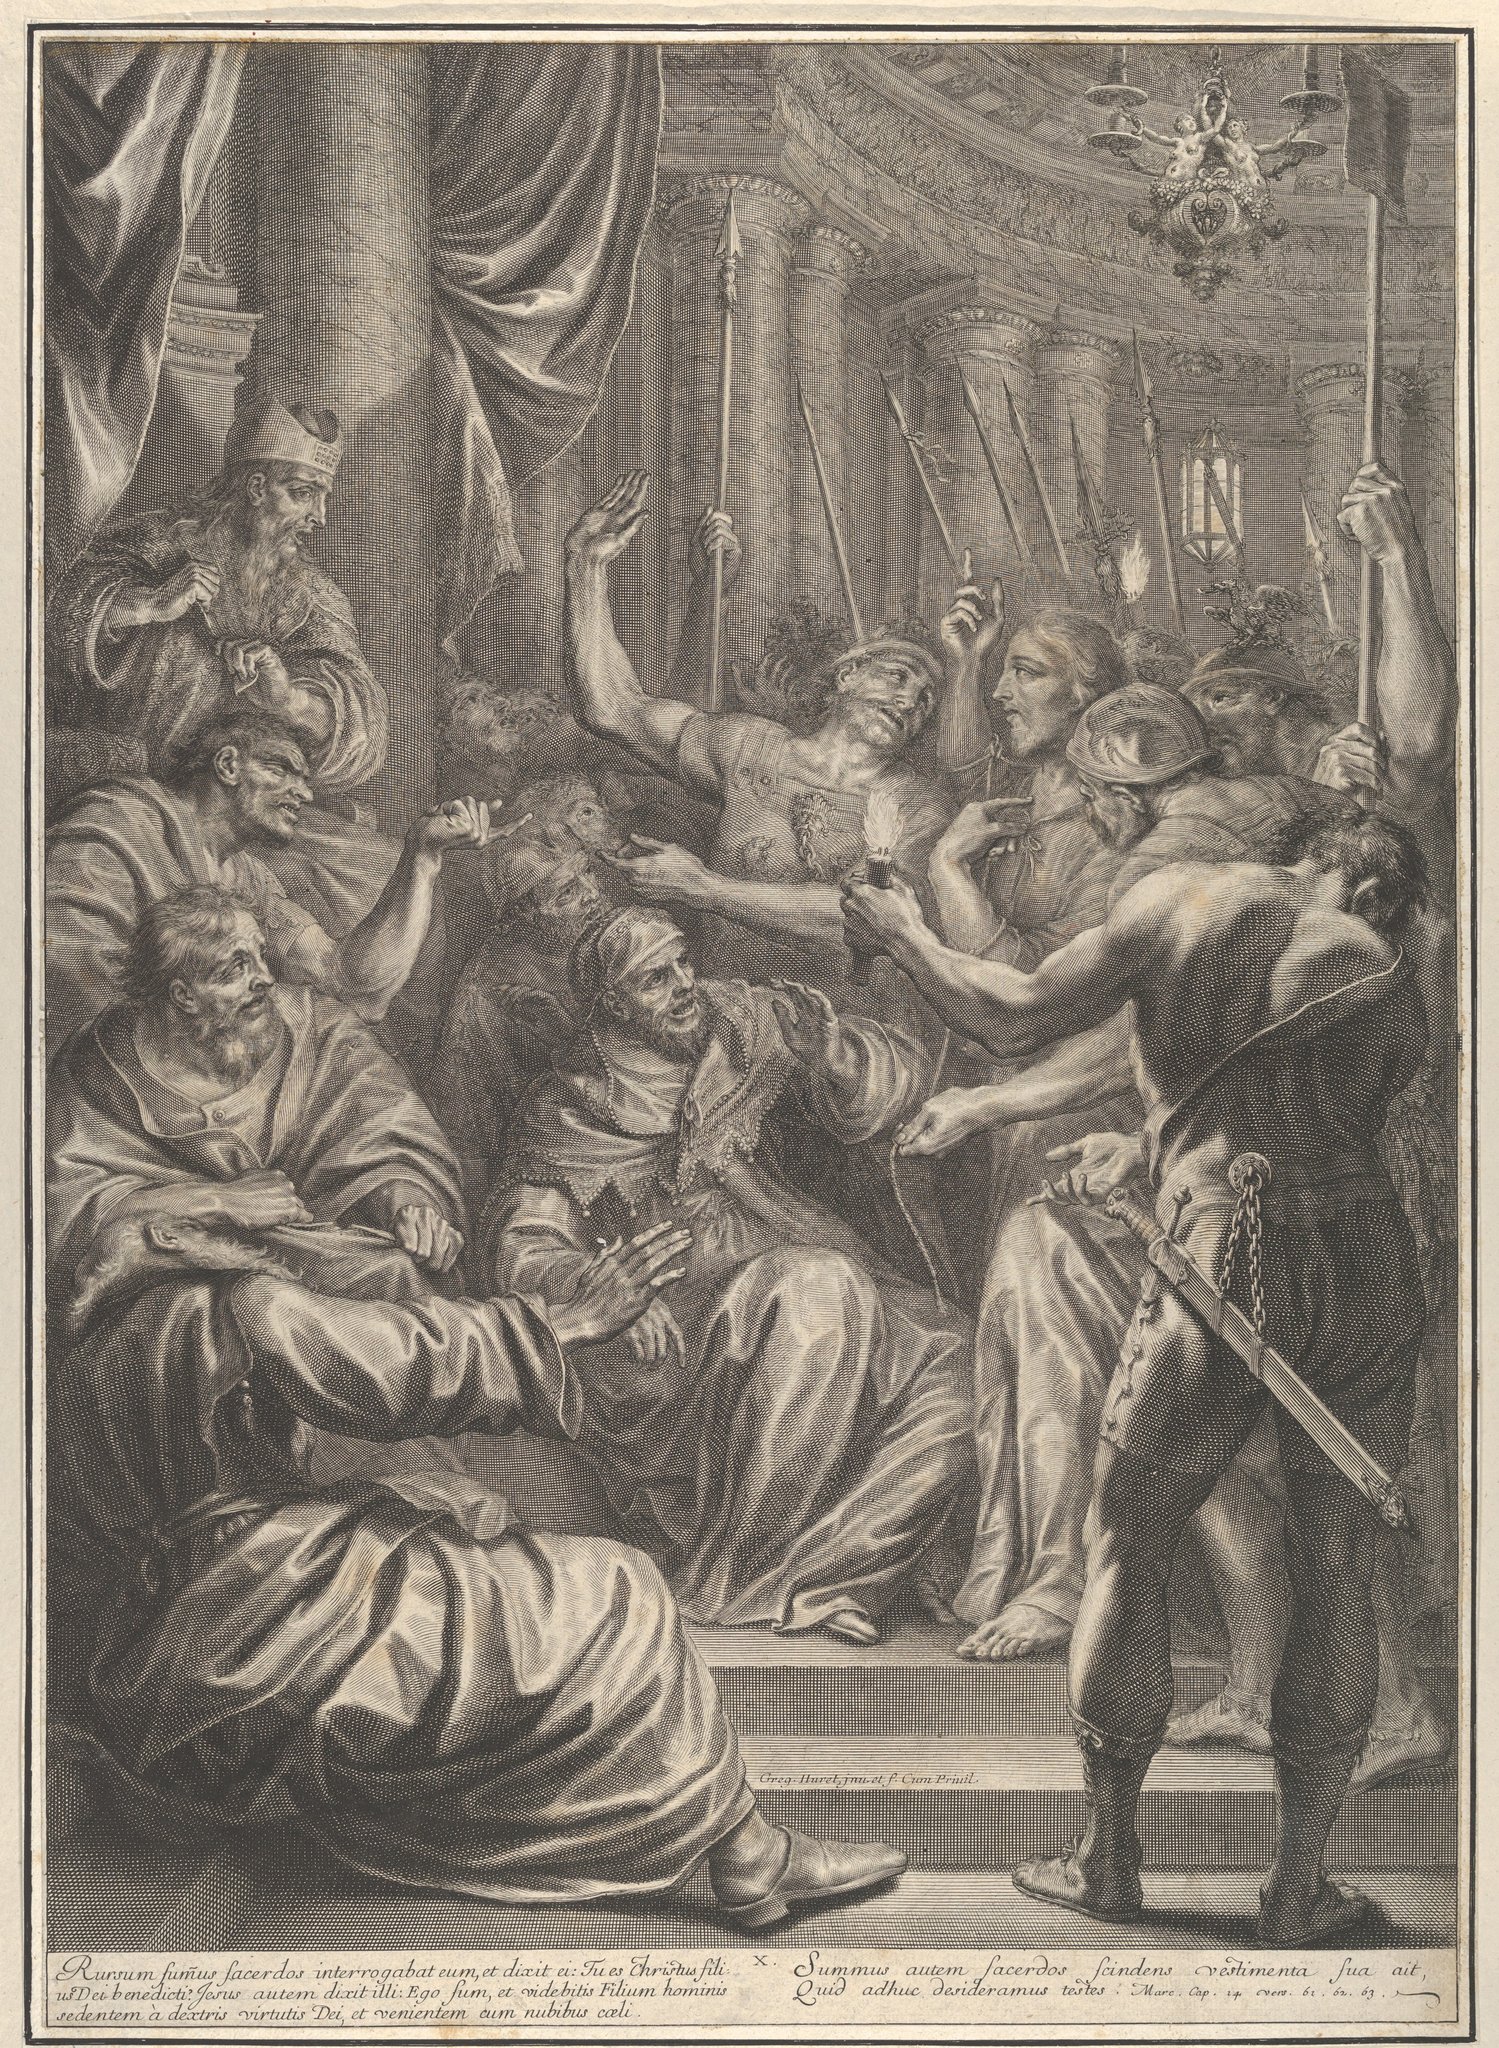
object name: print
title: Christ Before Caiaphas, from The Passion of Christ, plate 10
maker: grégoire huret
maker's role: artist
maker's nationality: french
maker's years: 1606-1670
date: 1664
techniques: engraving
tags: weapons,christ